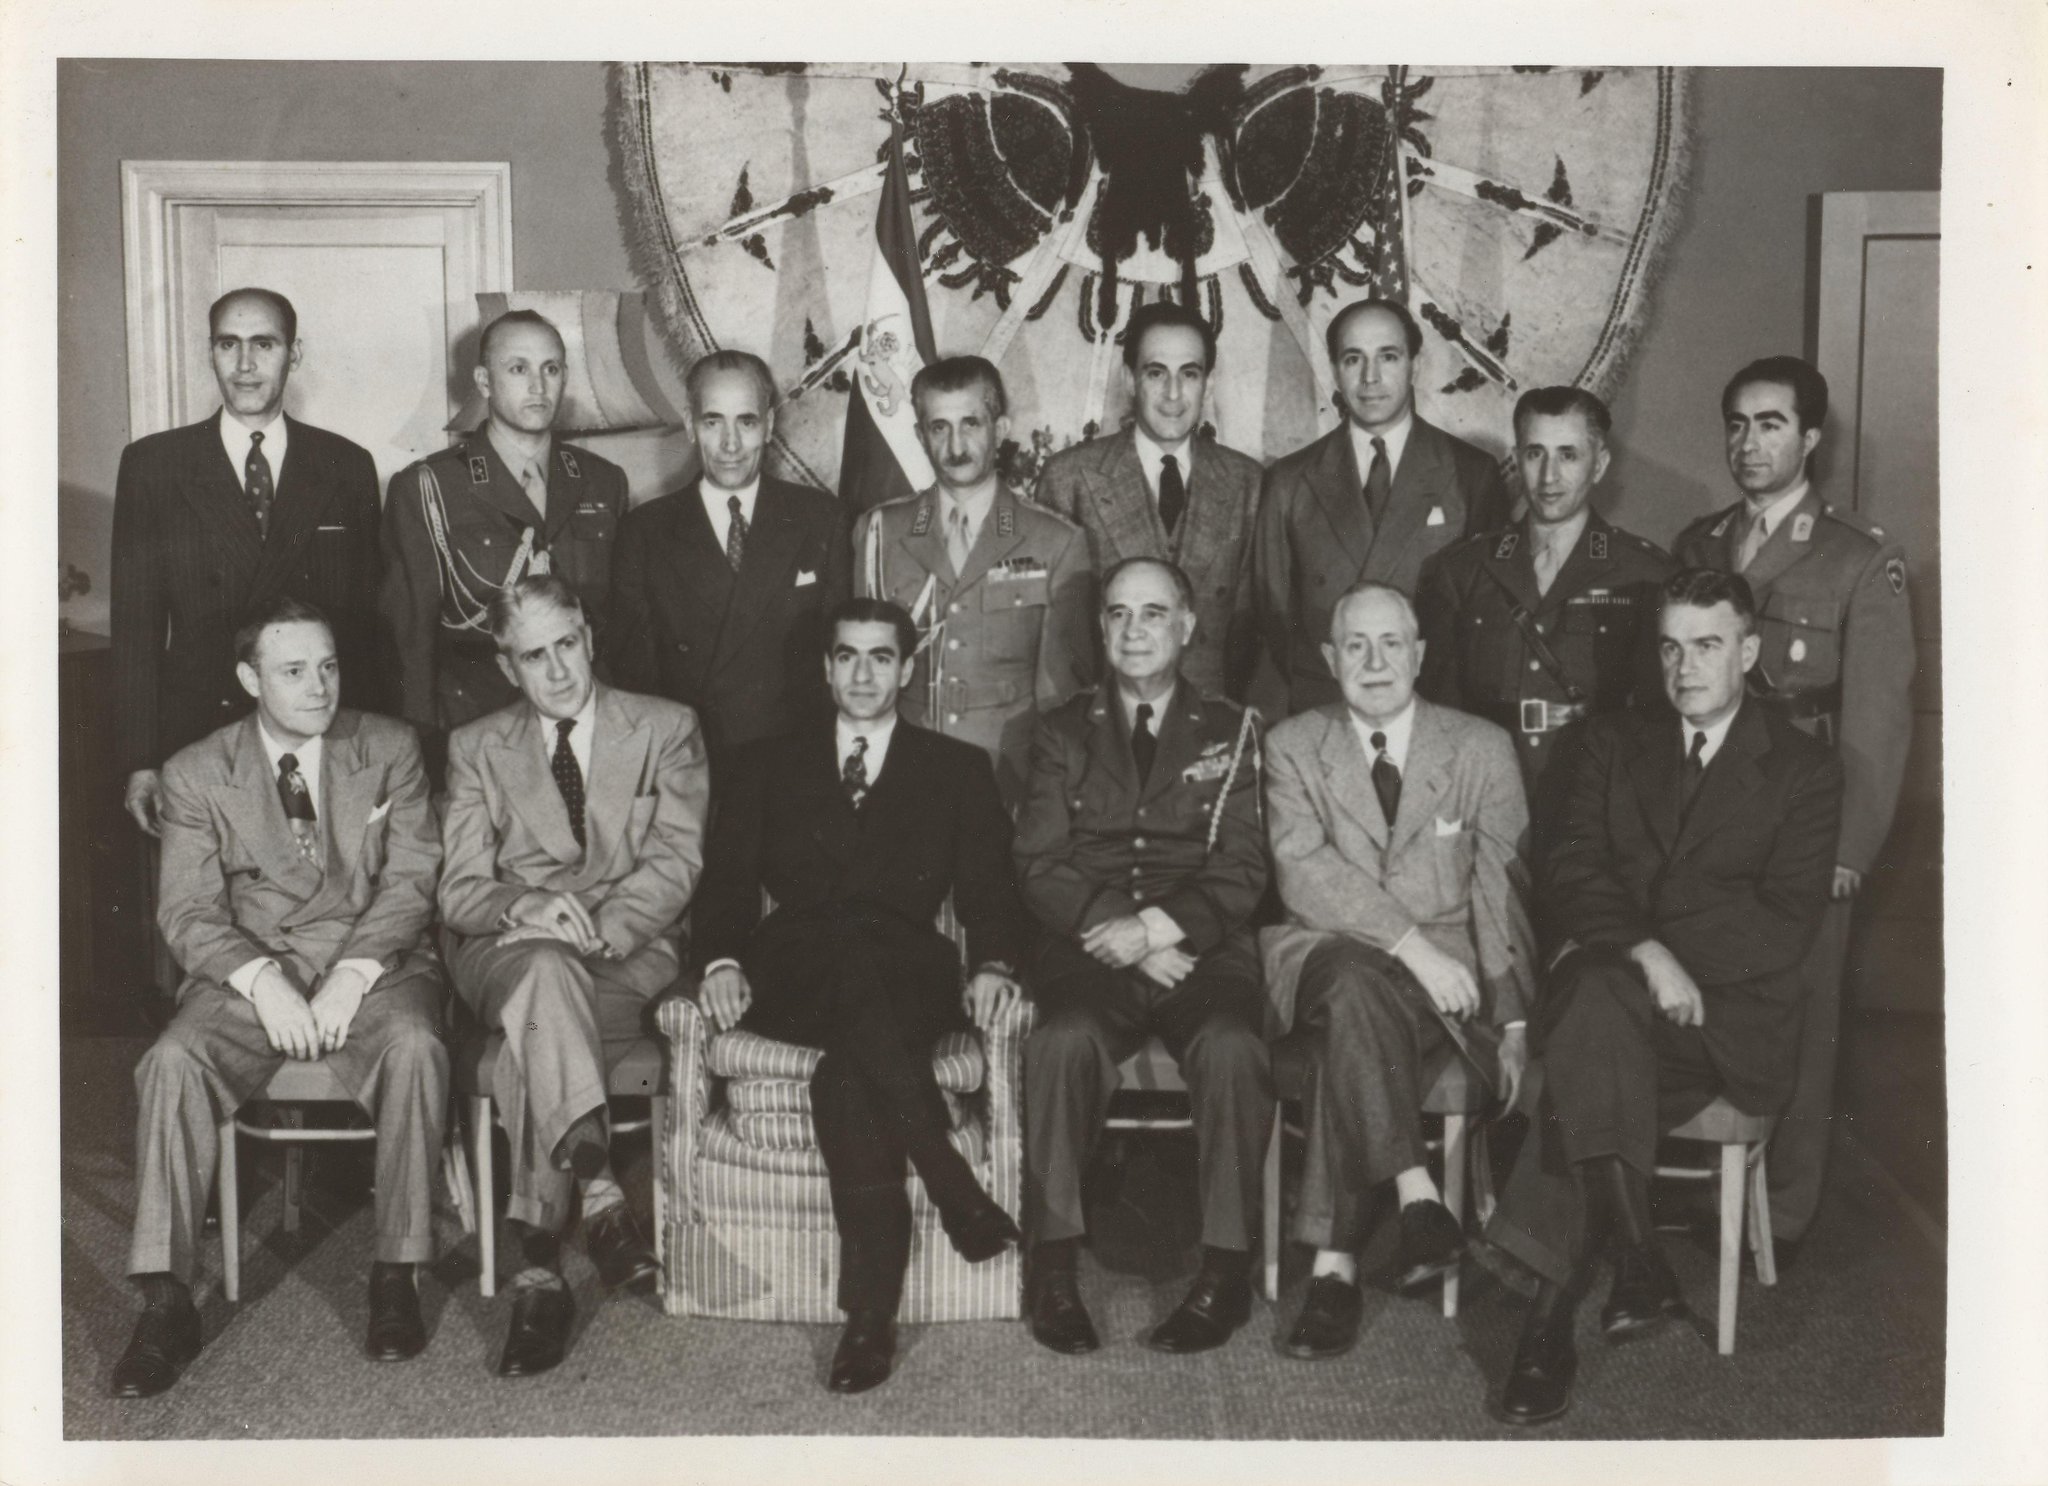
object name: photograph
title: De sjah van Iran en zijn regering in Sun Valley Idaho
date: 1949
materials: photographic support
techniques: gelatin silver print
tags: united states of america